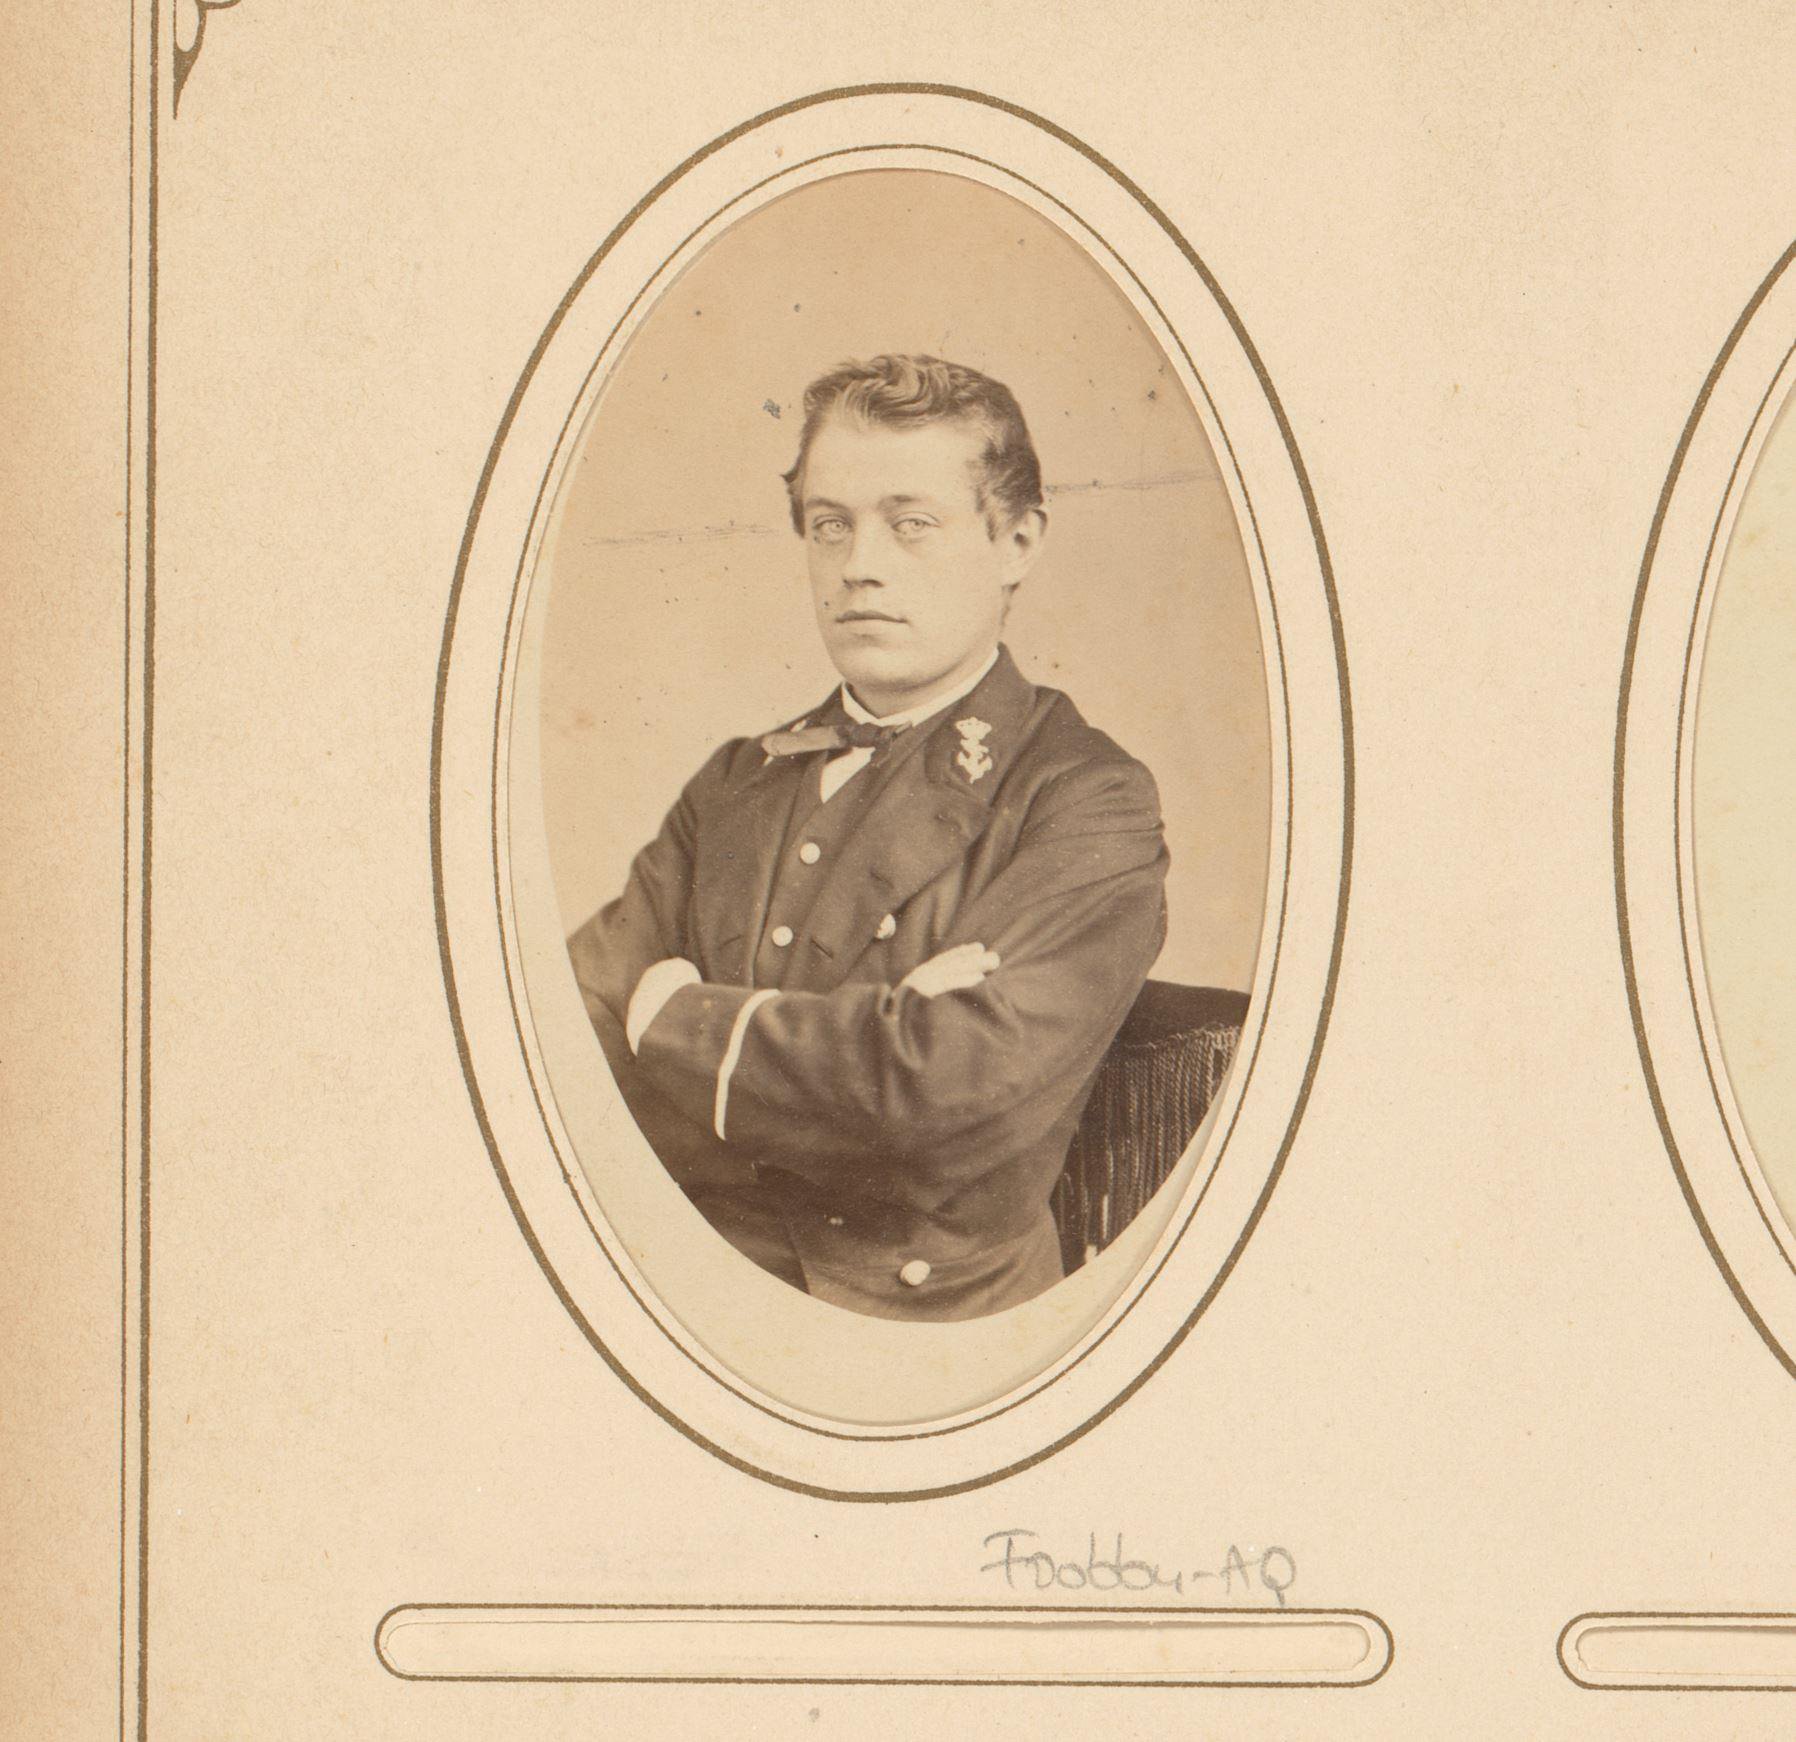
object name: carte de visite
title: Portret van een jongeman met insignes op jas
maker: heinrich steinhauer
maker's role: fotograaf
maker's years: 1838-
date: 1863-1875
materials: cardboard, photographic support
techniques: albumen print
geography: nieuwediep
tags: historical persons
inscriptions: inscription: ‘Photographie van H. Steinhauer/ Nieuwediep’